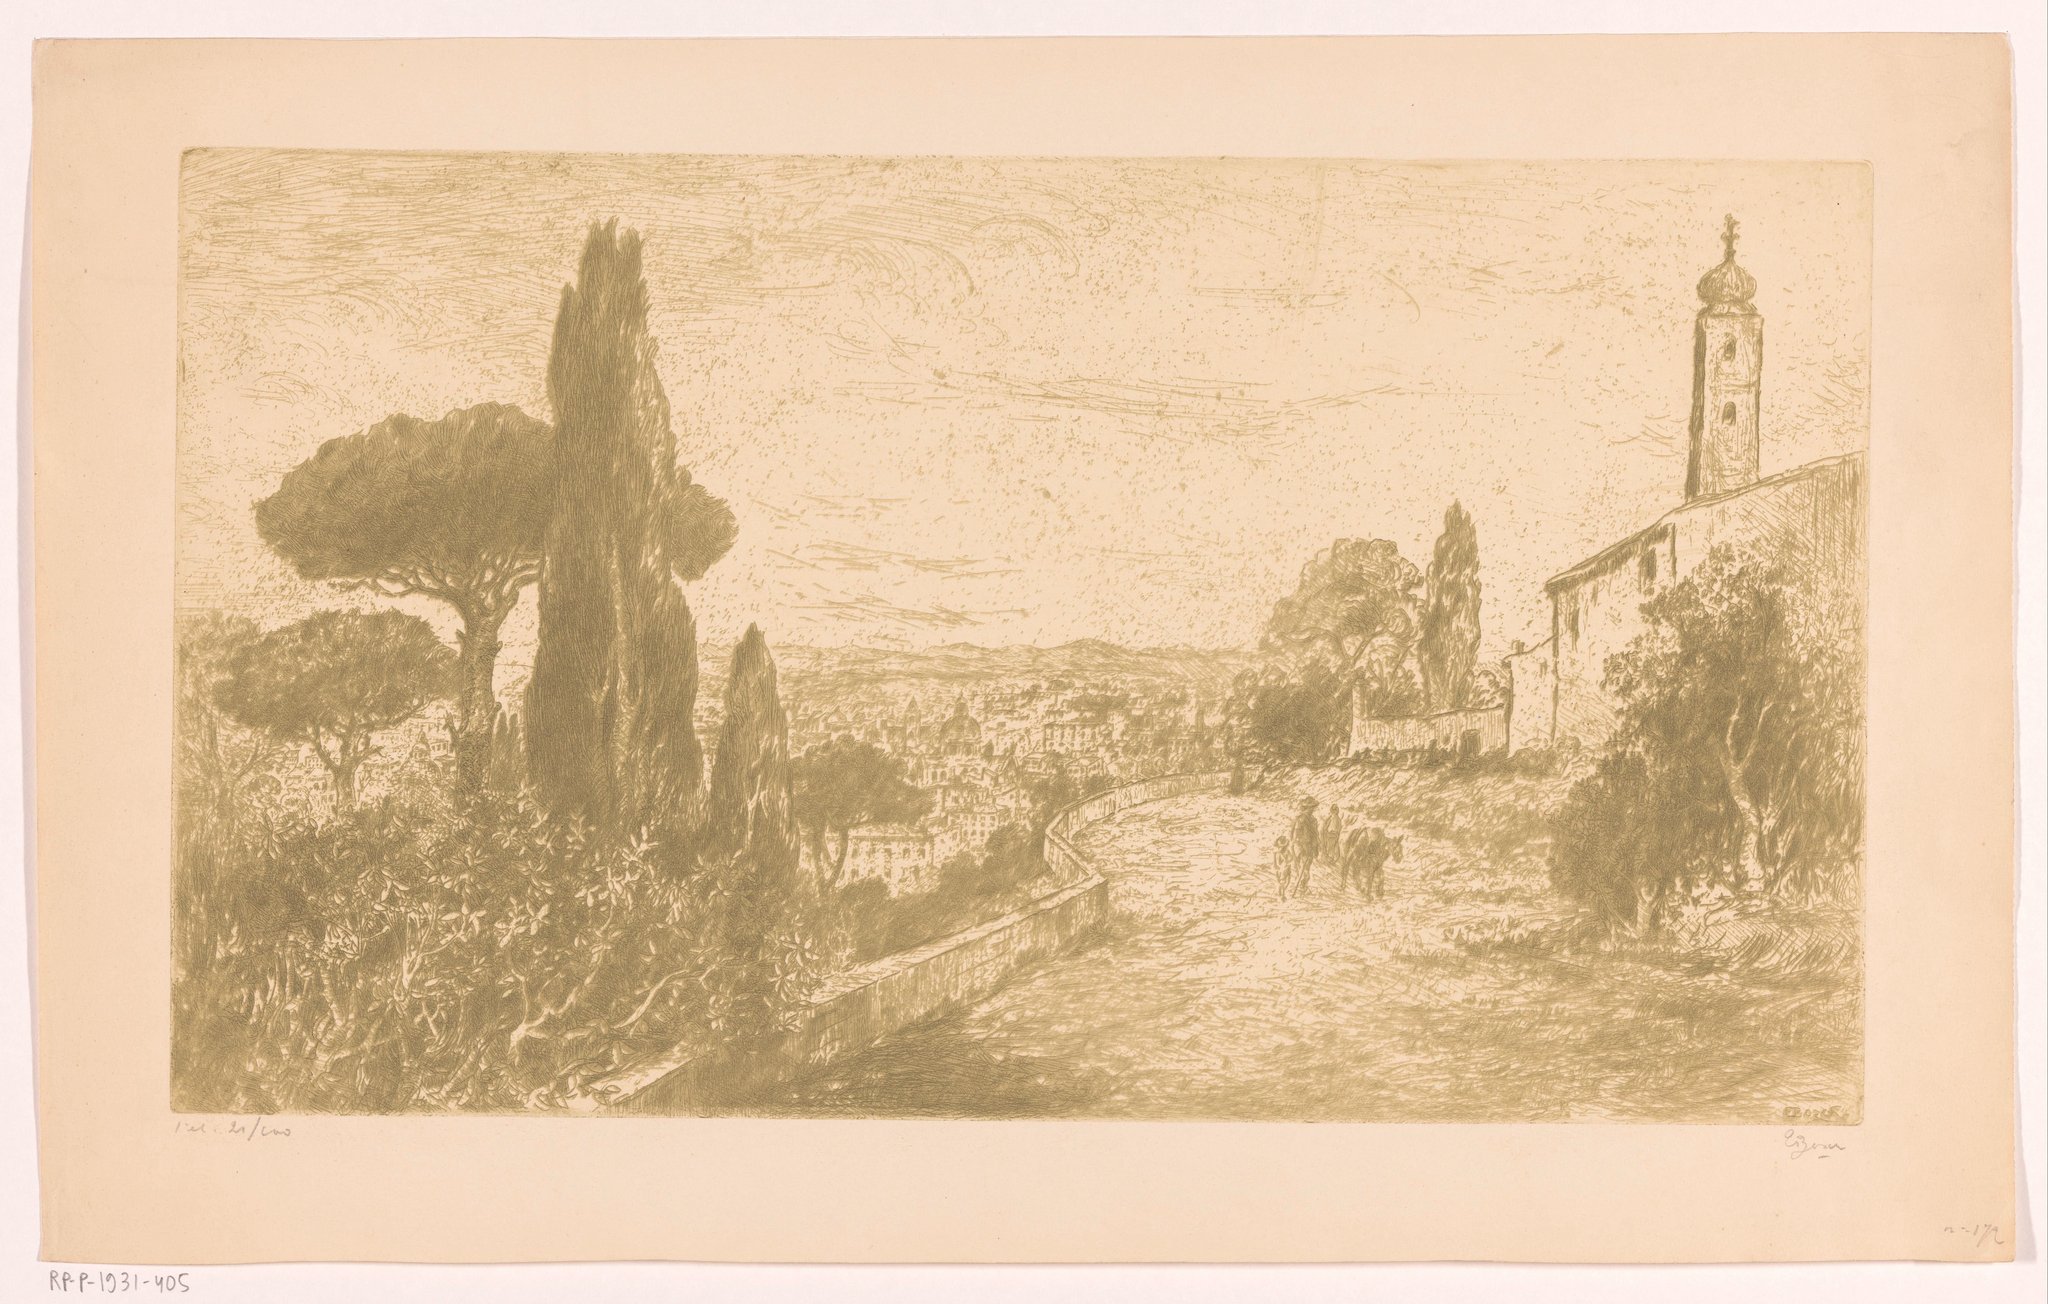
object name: print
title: Heuvel in Rome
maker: etienne bosch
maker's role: print maker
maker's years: 1863-1933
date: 1873-1931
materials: paper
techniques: etching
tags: city-view, and landscape with man-made constructions, low hill country, tower (of house or building), rome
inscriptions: collector's mark: Lugt 2228, number: ‘no. 172’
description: Een gebouw met een toren op een heuvel. Links zicht op de stad Rome.